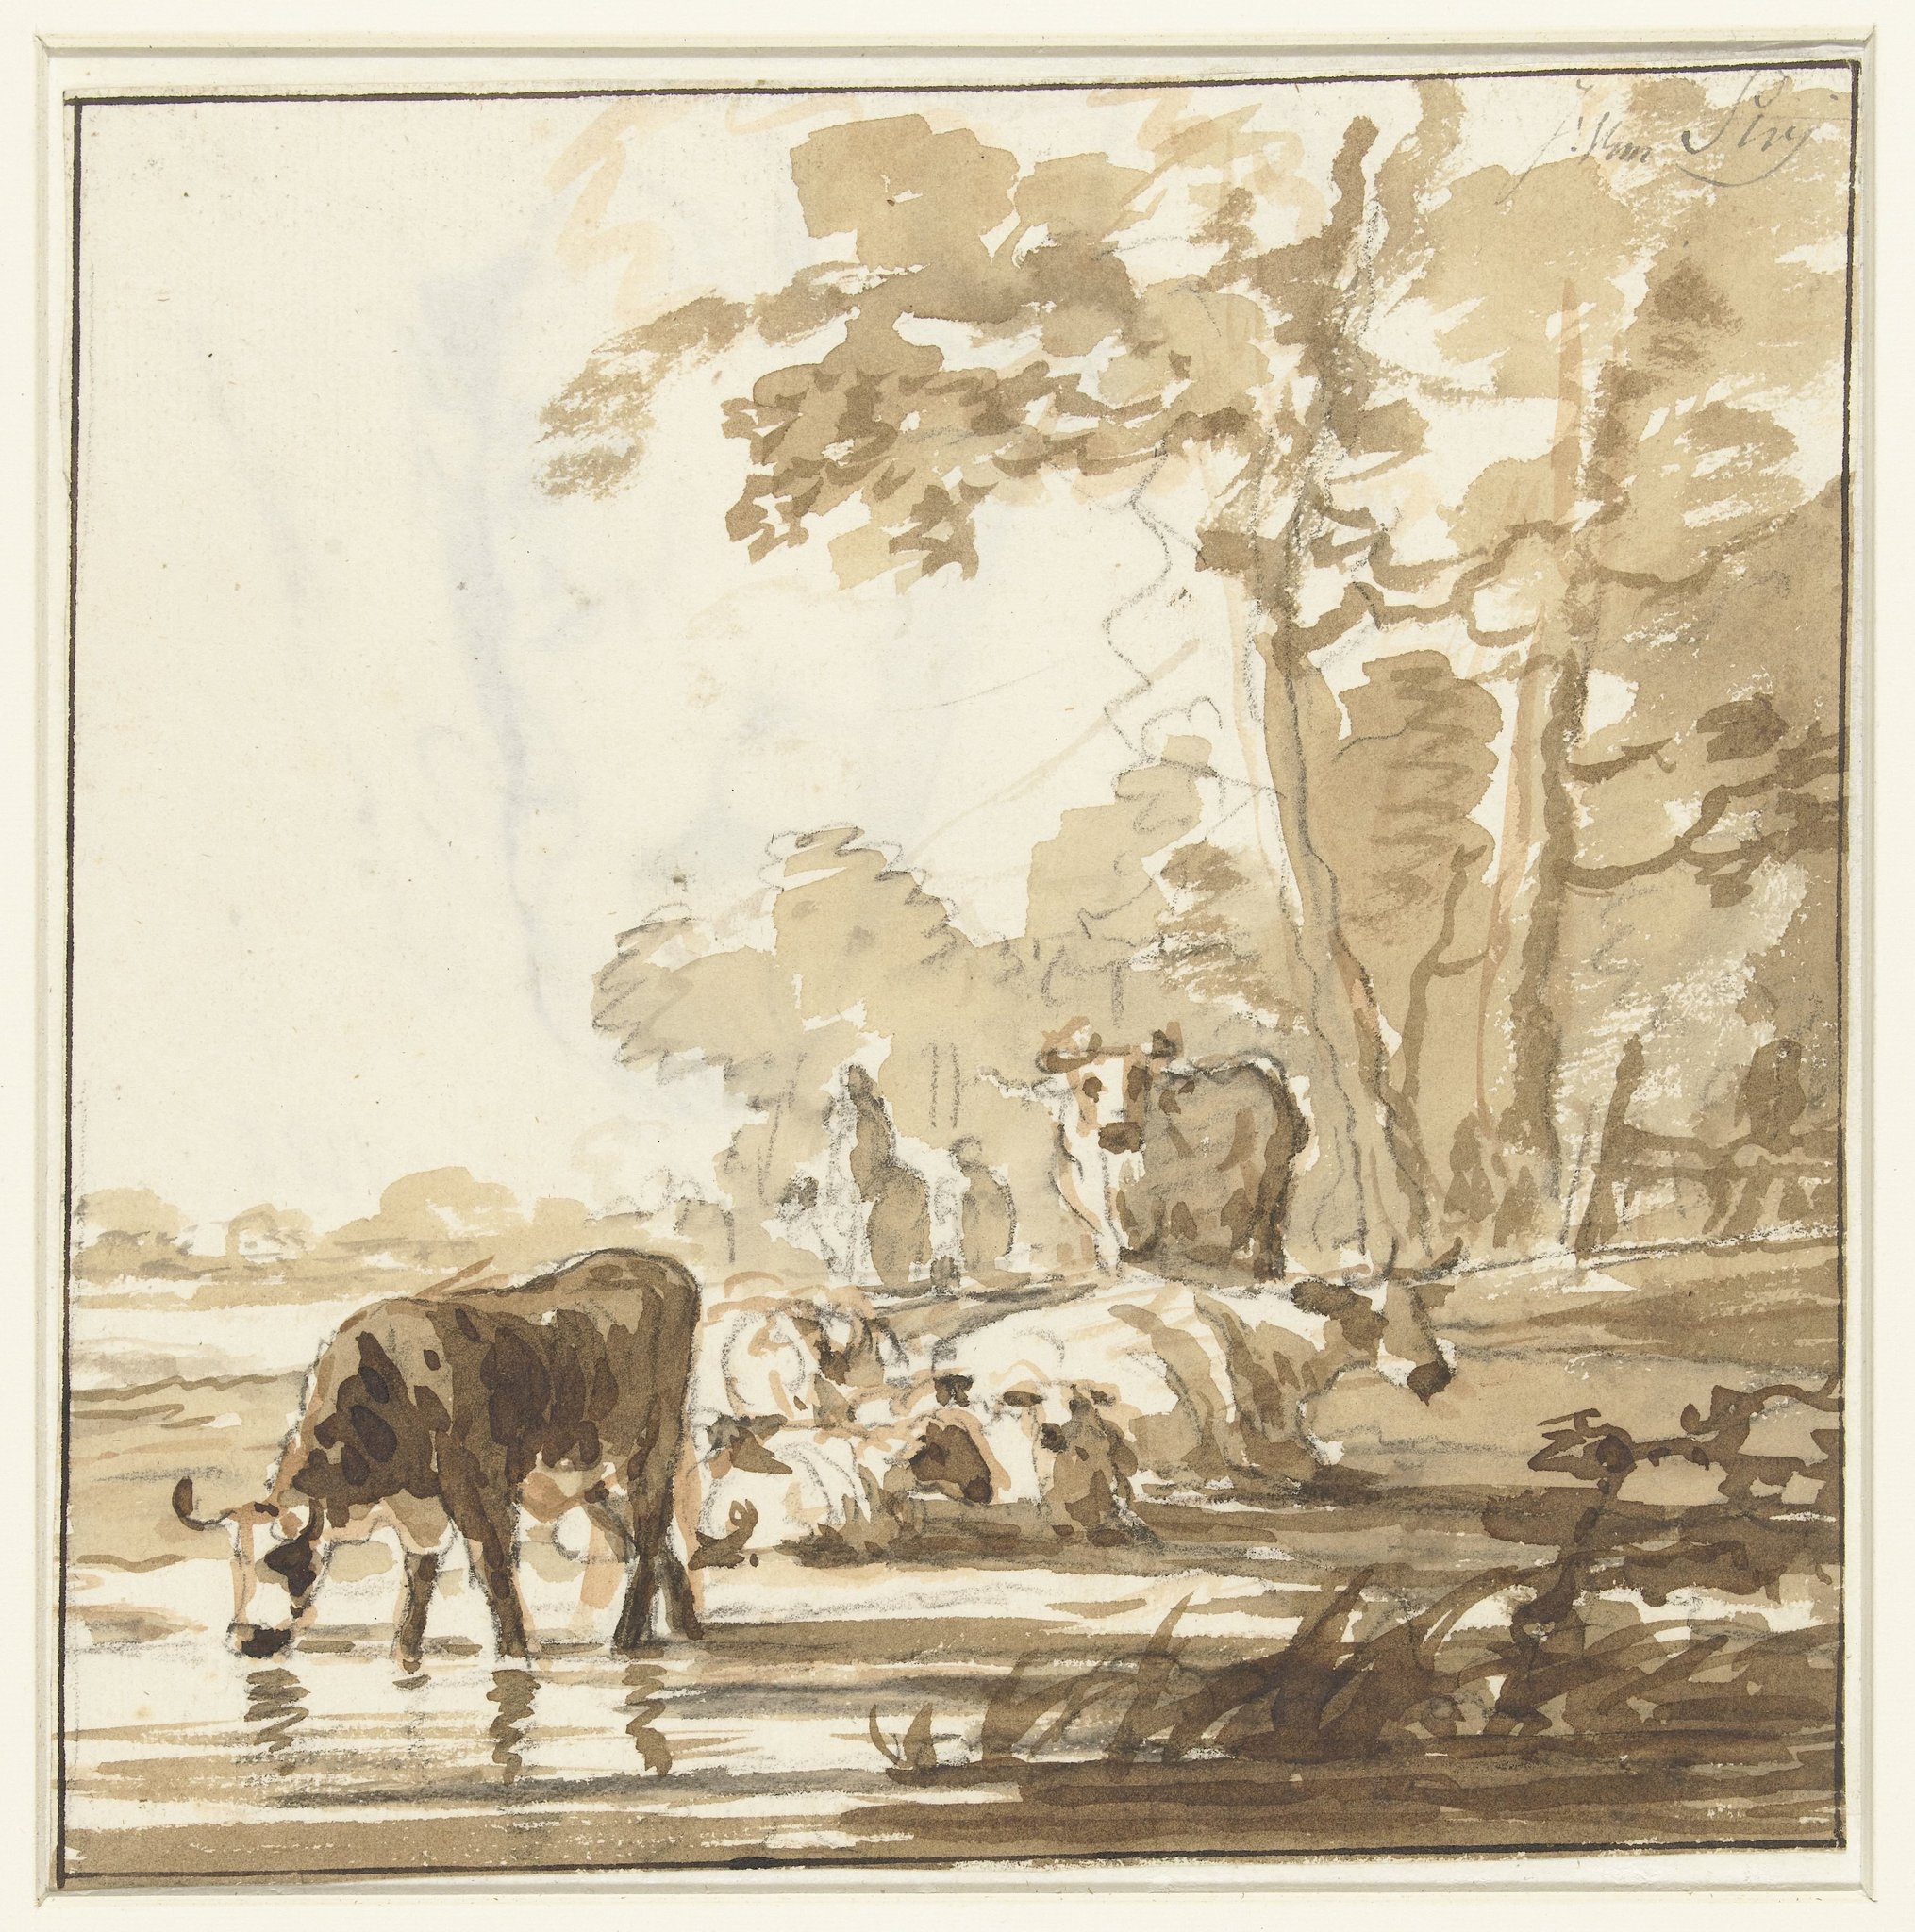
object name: drawing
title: Rustend vee aan een bosrand bij een poel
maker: jacob van strij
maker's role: draughtsman, painter, print maker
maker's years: 1756-1815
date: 1766-1815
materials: chalk, paper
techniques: brush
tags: landscapes, bovine cattle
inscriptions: signature: ‘J. van Strij’